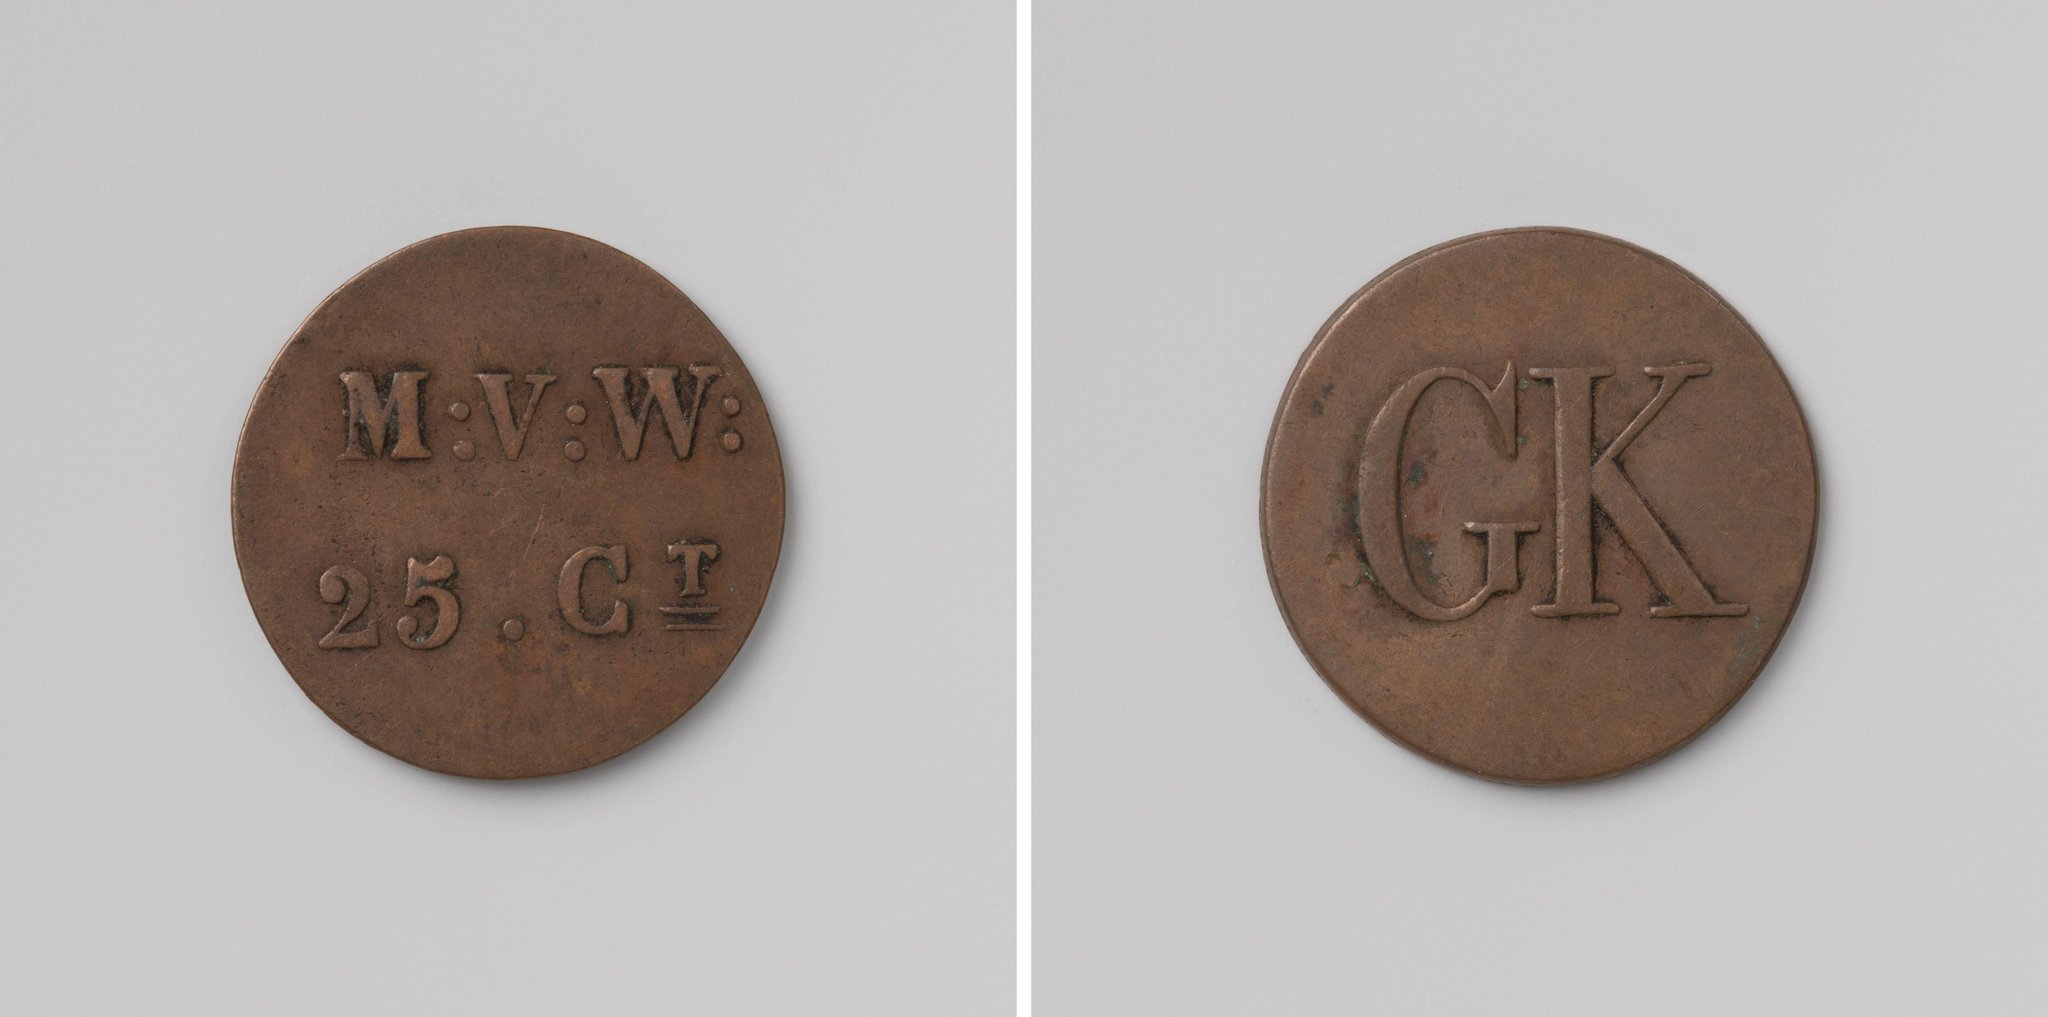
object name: huismunt prison money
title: Huismunt geslagen op last van de Maatschappij van Weldadigheid ter waarde van 25 cent, ten behoeve van de Gewone Koloniën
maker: Anonymous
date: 1818-1859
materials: copper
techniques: striking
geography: netherlands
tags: maatschappij van weldadigheid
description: Voorzijde: opschrift boven waardeaanduiding. Keerzijde: opschrift G en K